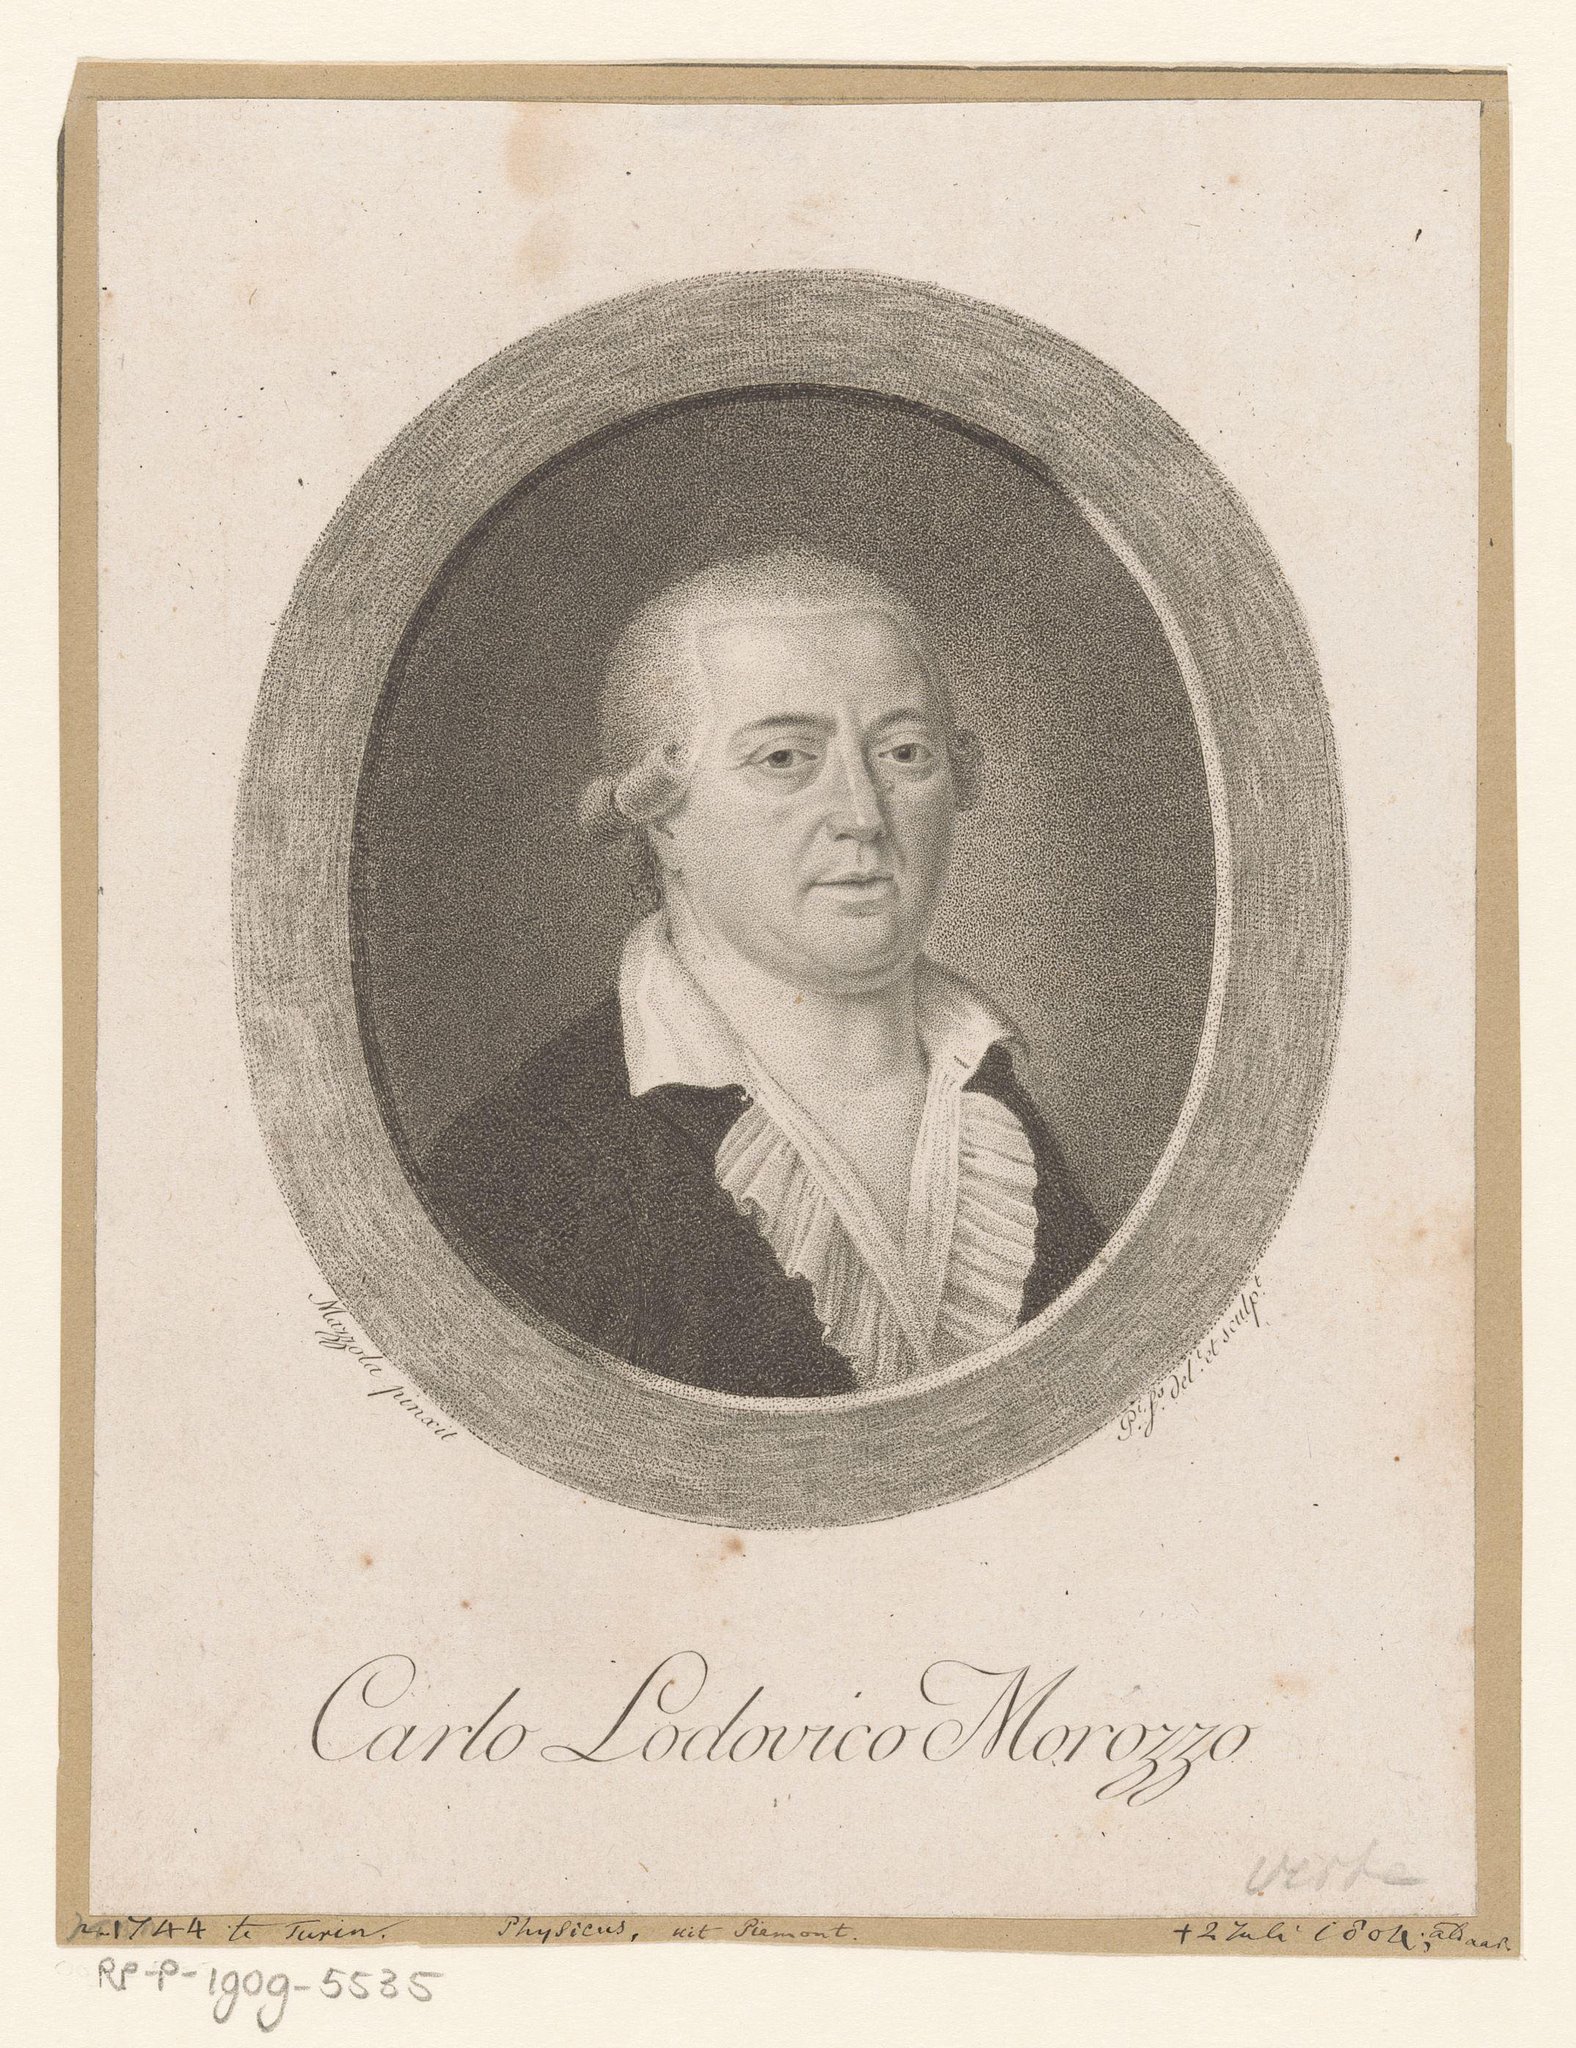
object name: print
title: Portret van bioloog en chemicus Carlo Lodovico Morozzo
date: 1800-1899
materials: paper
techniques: intaglio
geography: italy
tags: historical persons, science and technology (+ portrait of scholar, scientist)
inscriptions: collector's mark: Lugt 2228